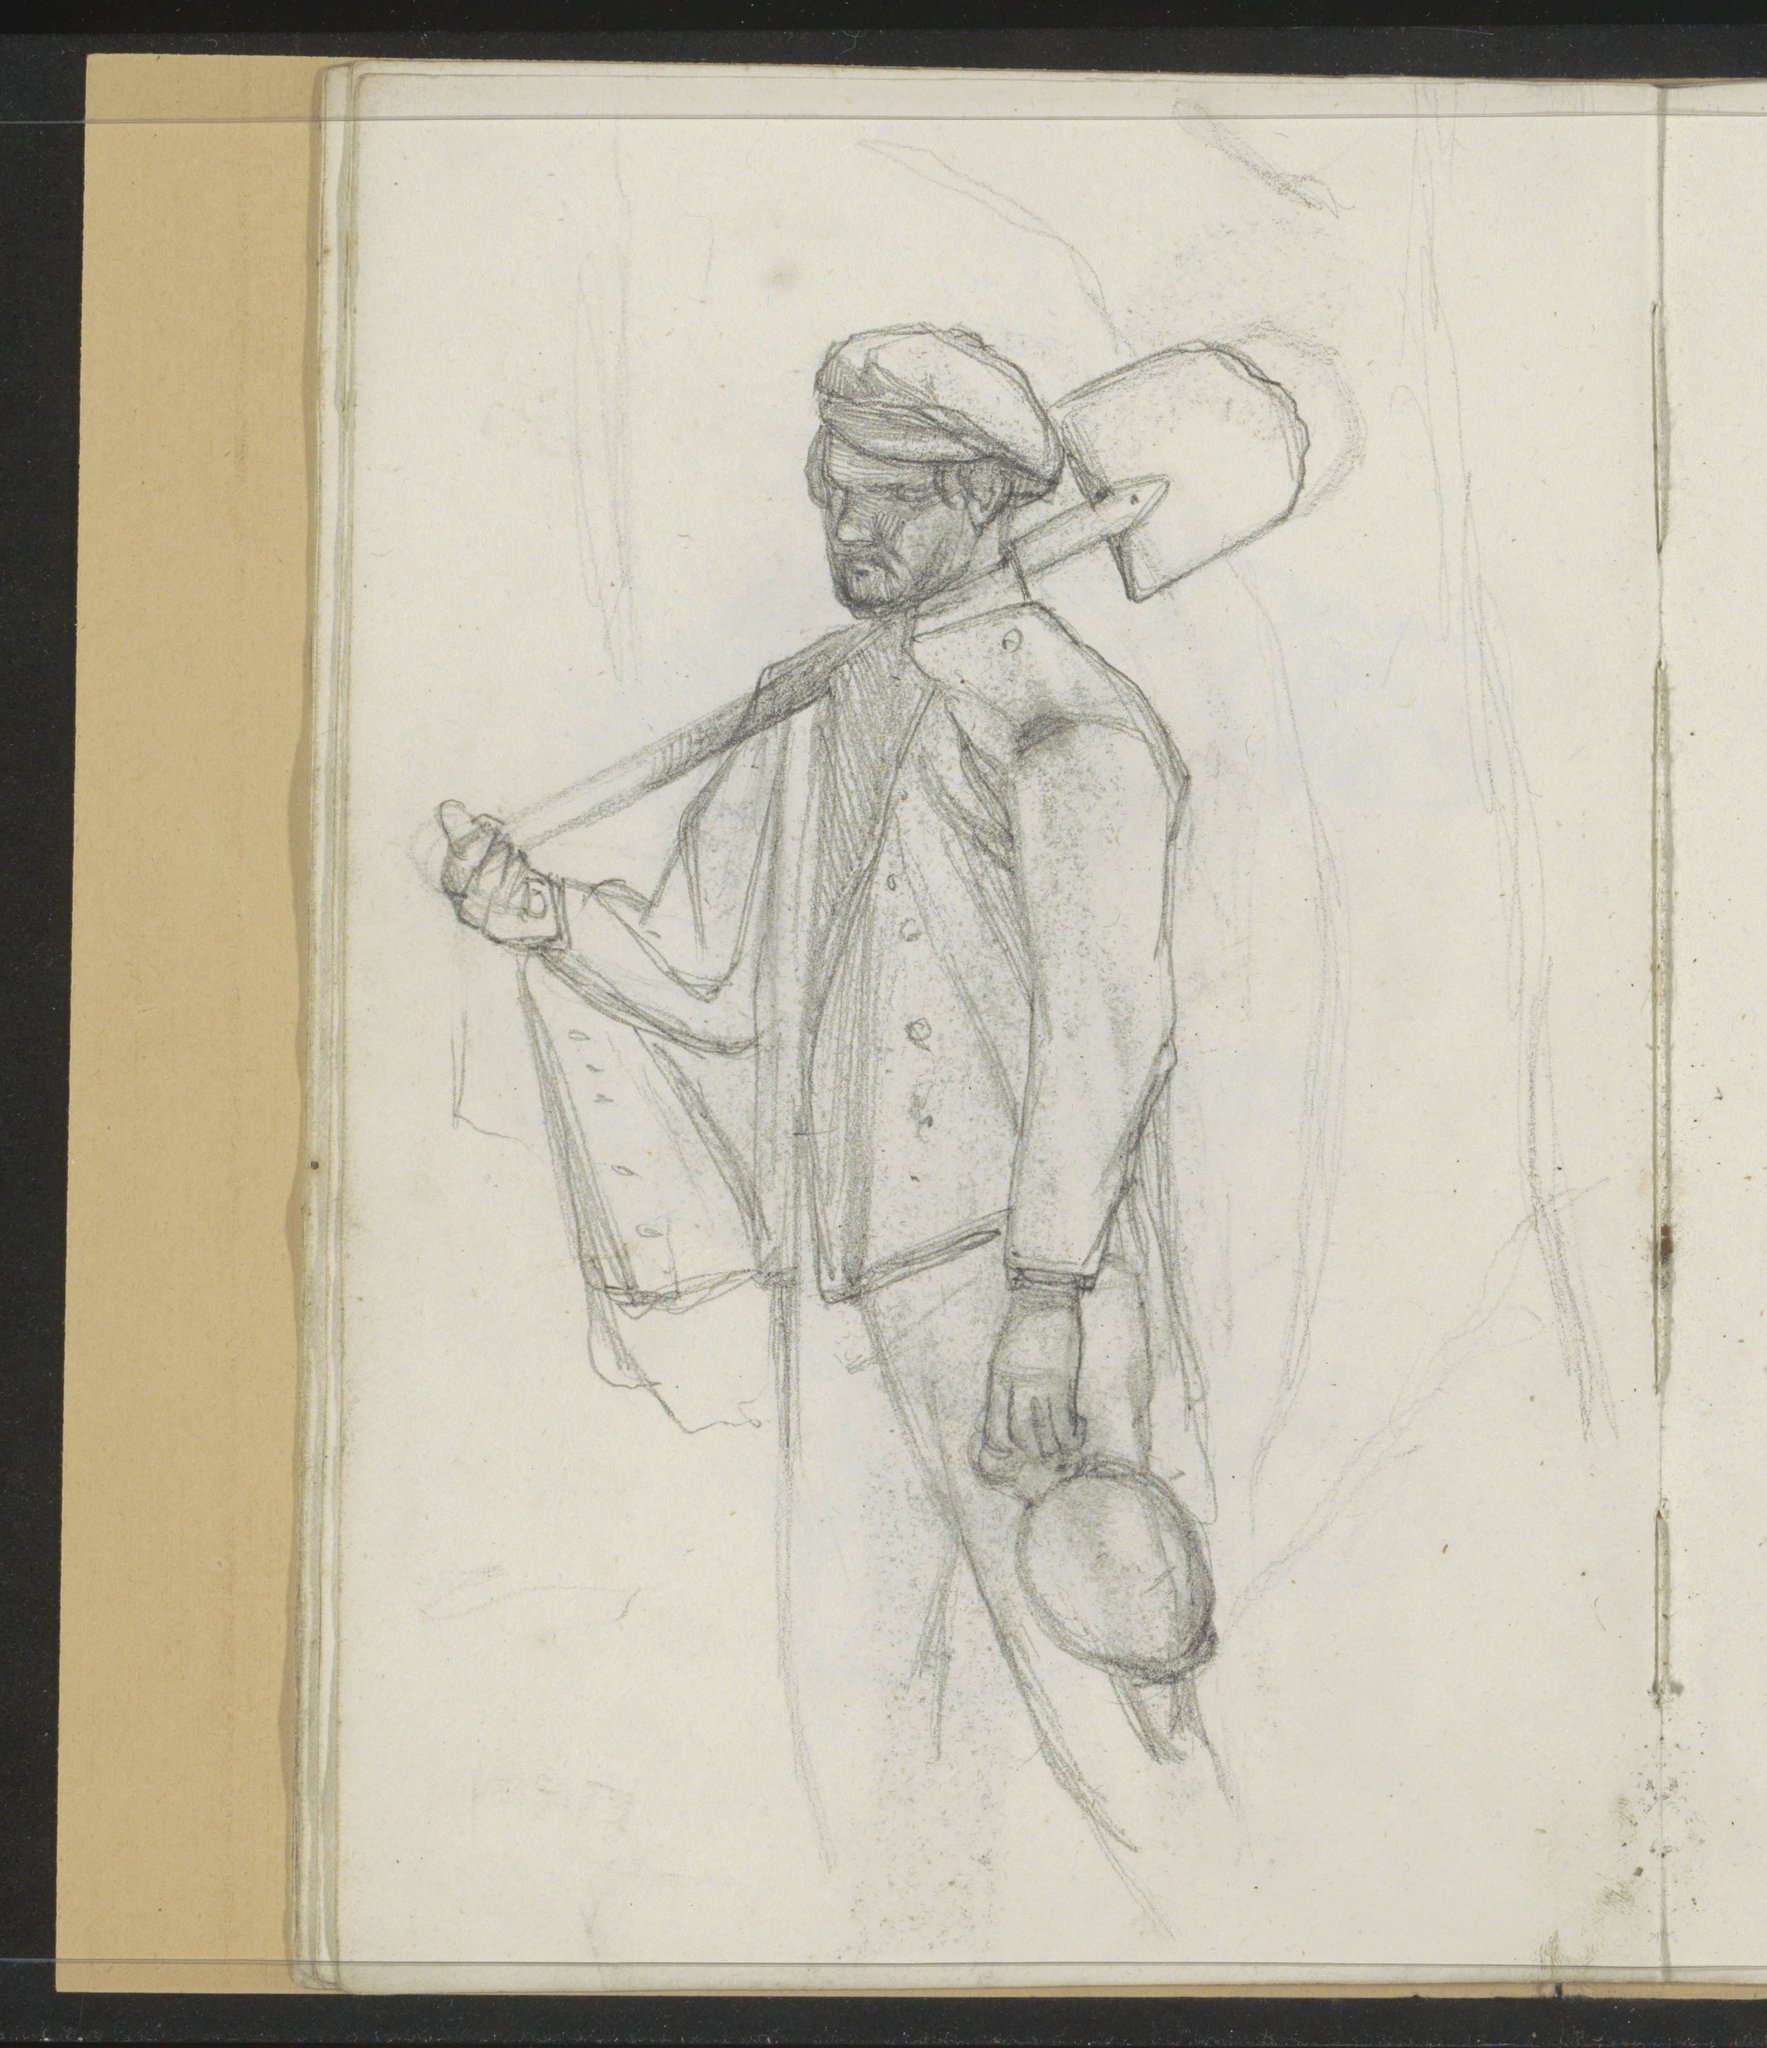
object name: sketchbook leaf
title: Man met een schop en een kroes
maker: jozef israëls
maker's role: draughtsman, painter, print maker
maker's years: 1824-1911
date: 1834-1911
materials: paper, pencil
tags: adult man, jar, jug (used as drinking-vessel), agricultural implements: spade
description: De man draagt de schop op zijn schouder. Blad 7 verso uit een schetsboek met 16 bladen.